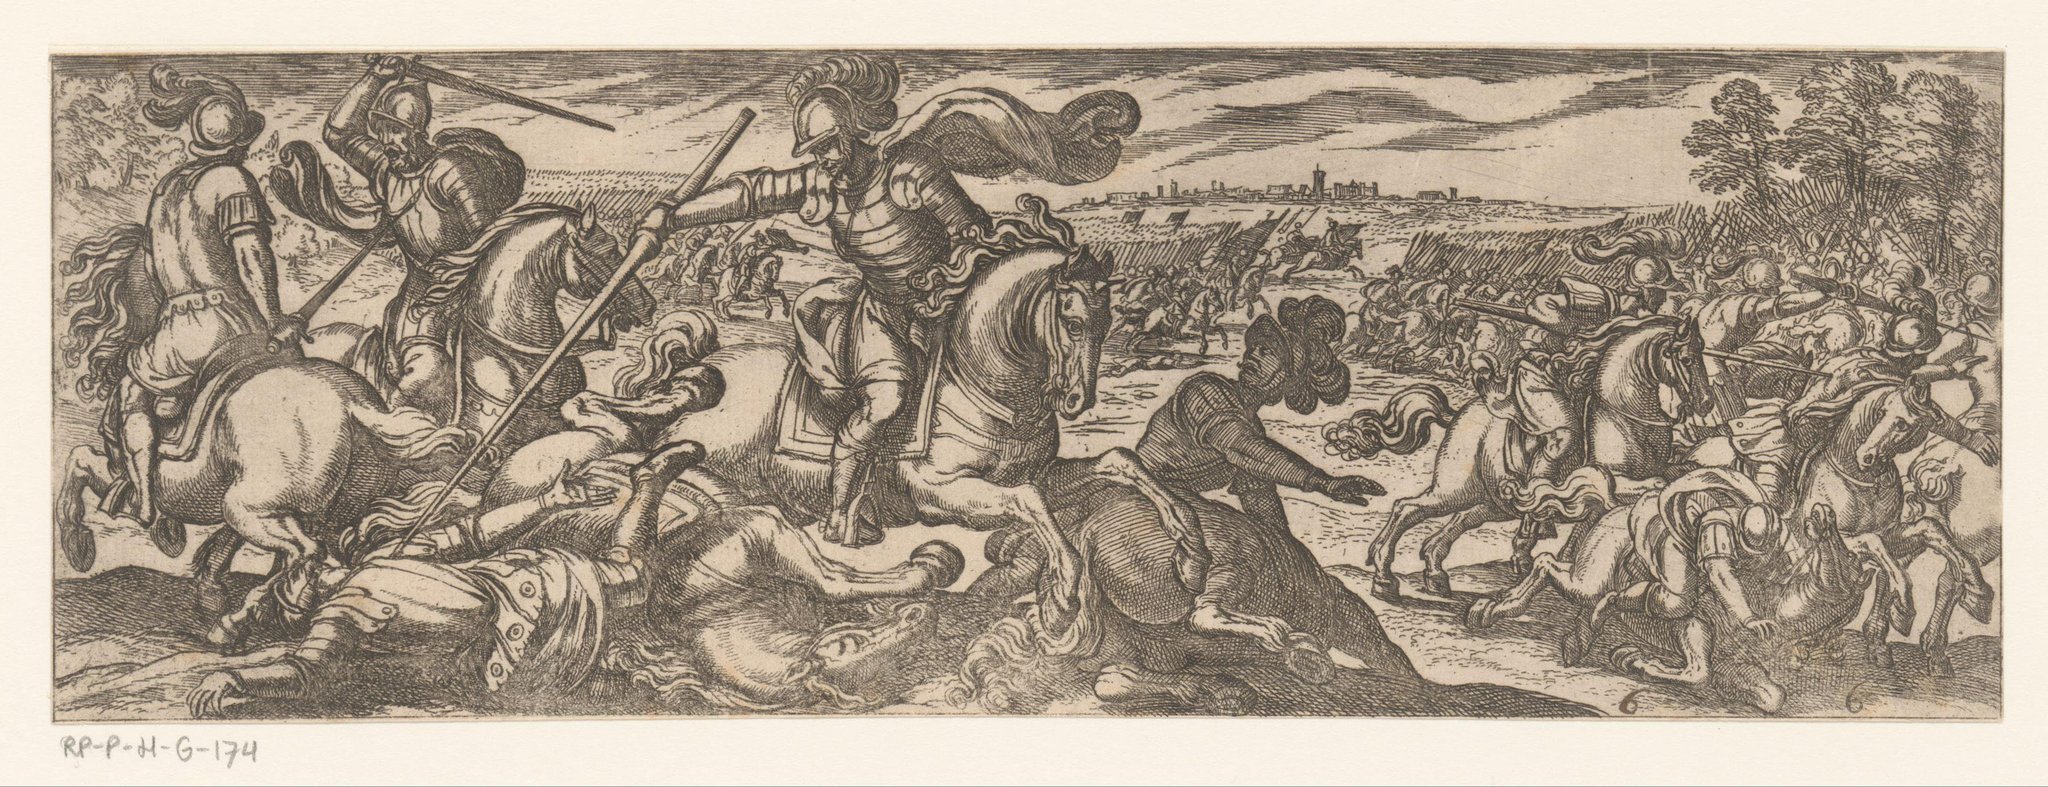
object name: print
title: Strijdende soldaten te paard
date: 1599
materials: paper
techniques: etching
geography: italy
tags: military service, warfare; military affairs (+ cavalry, horsemen), the soldier; the soldier's life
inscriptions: collector's mark: ‘Hinloopen’, number: ‘6’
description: Deze prent maakt deel uit van een reeks van 9 prenten (+ titelprent) met gevechtsscènes. Antonio Tempesta maakte ook een eerdere serie met gevechtsscènes van 10 prenten (+titelprent).